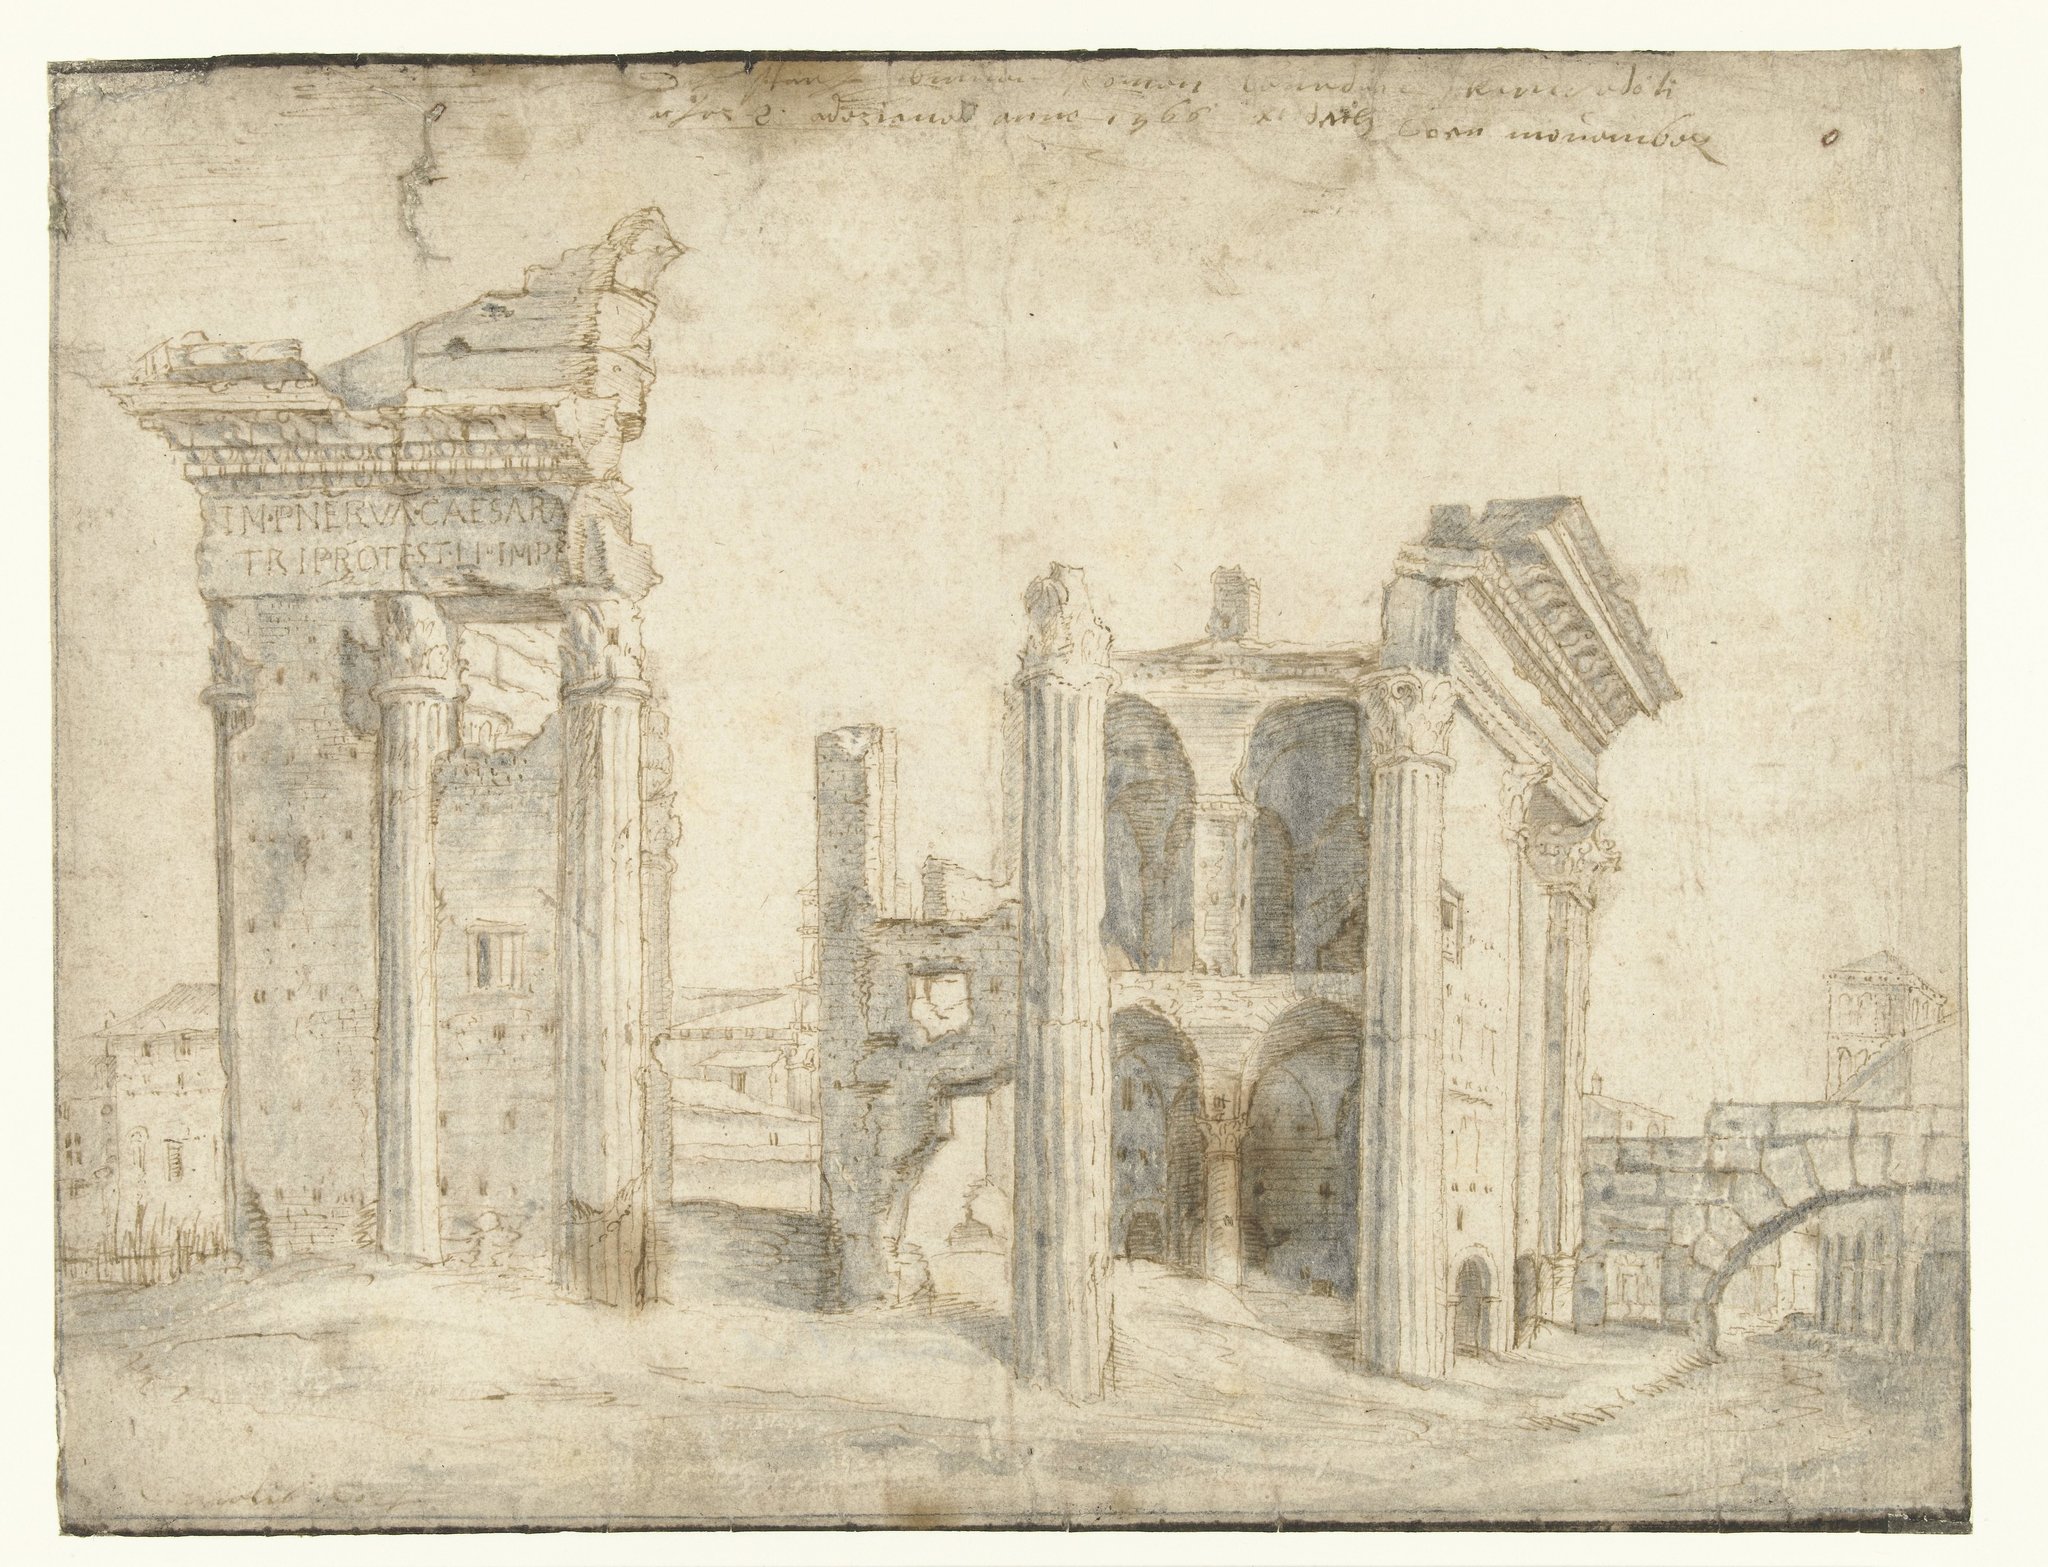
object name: drawing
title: Tempel van Minerva op het forum van Nerva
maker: cornelis cort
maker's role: print maker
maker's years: 1533-1578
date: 1566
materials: paper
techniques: brush, pen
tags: (story of) minerva (pallas, athena)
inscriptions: annotation: ‘Dit staat binnen Romen beneden Kampidoli ad foro Nerviano anno 1566 XI dach van november.’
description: Rechts de zogenaamde Arca di Noé en daarachter de toren van de kerk van Quirico en Giulitta.